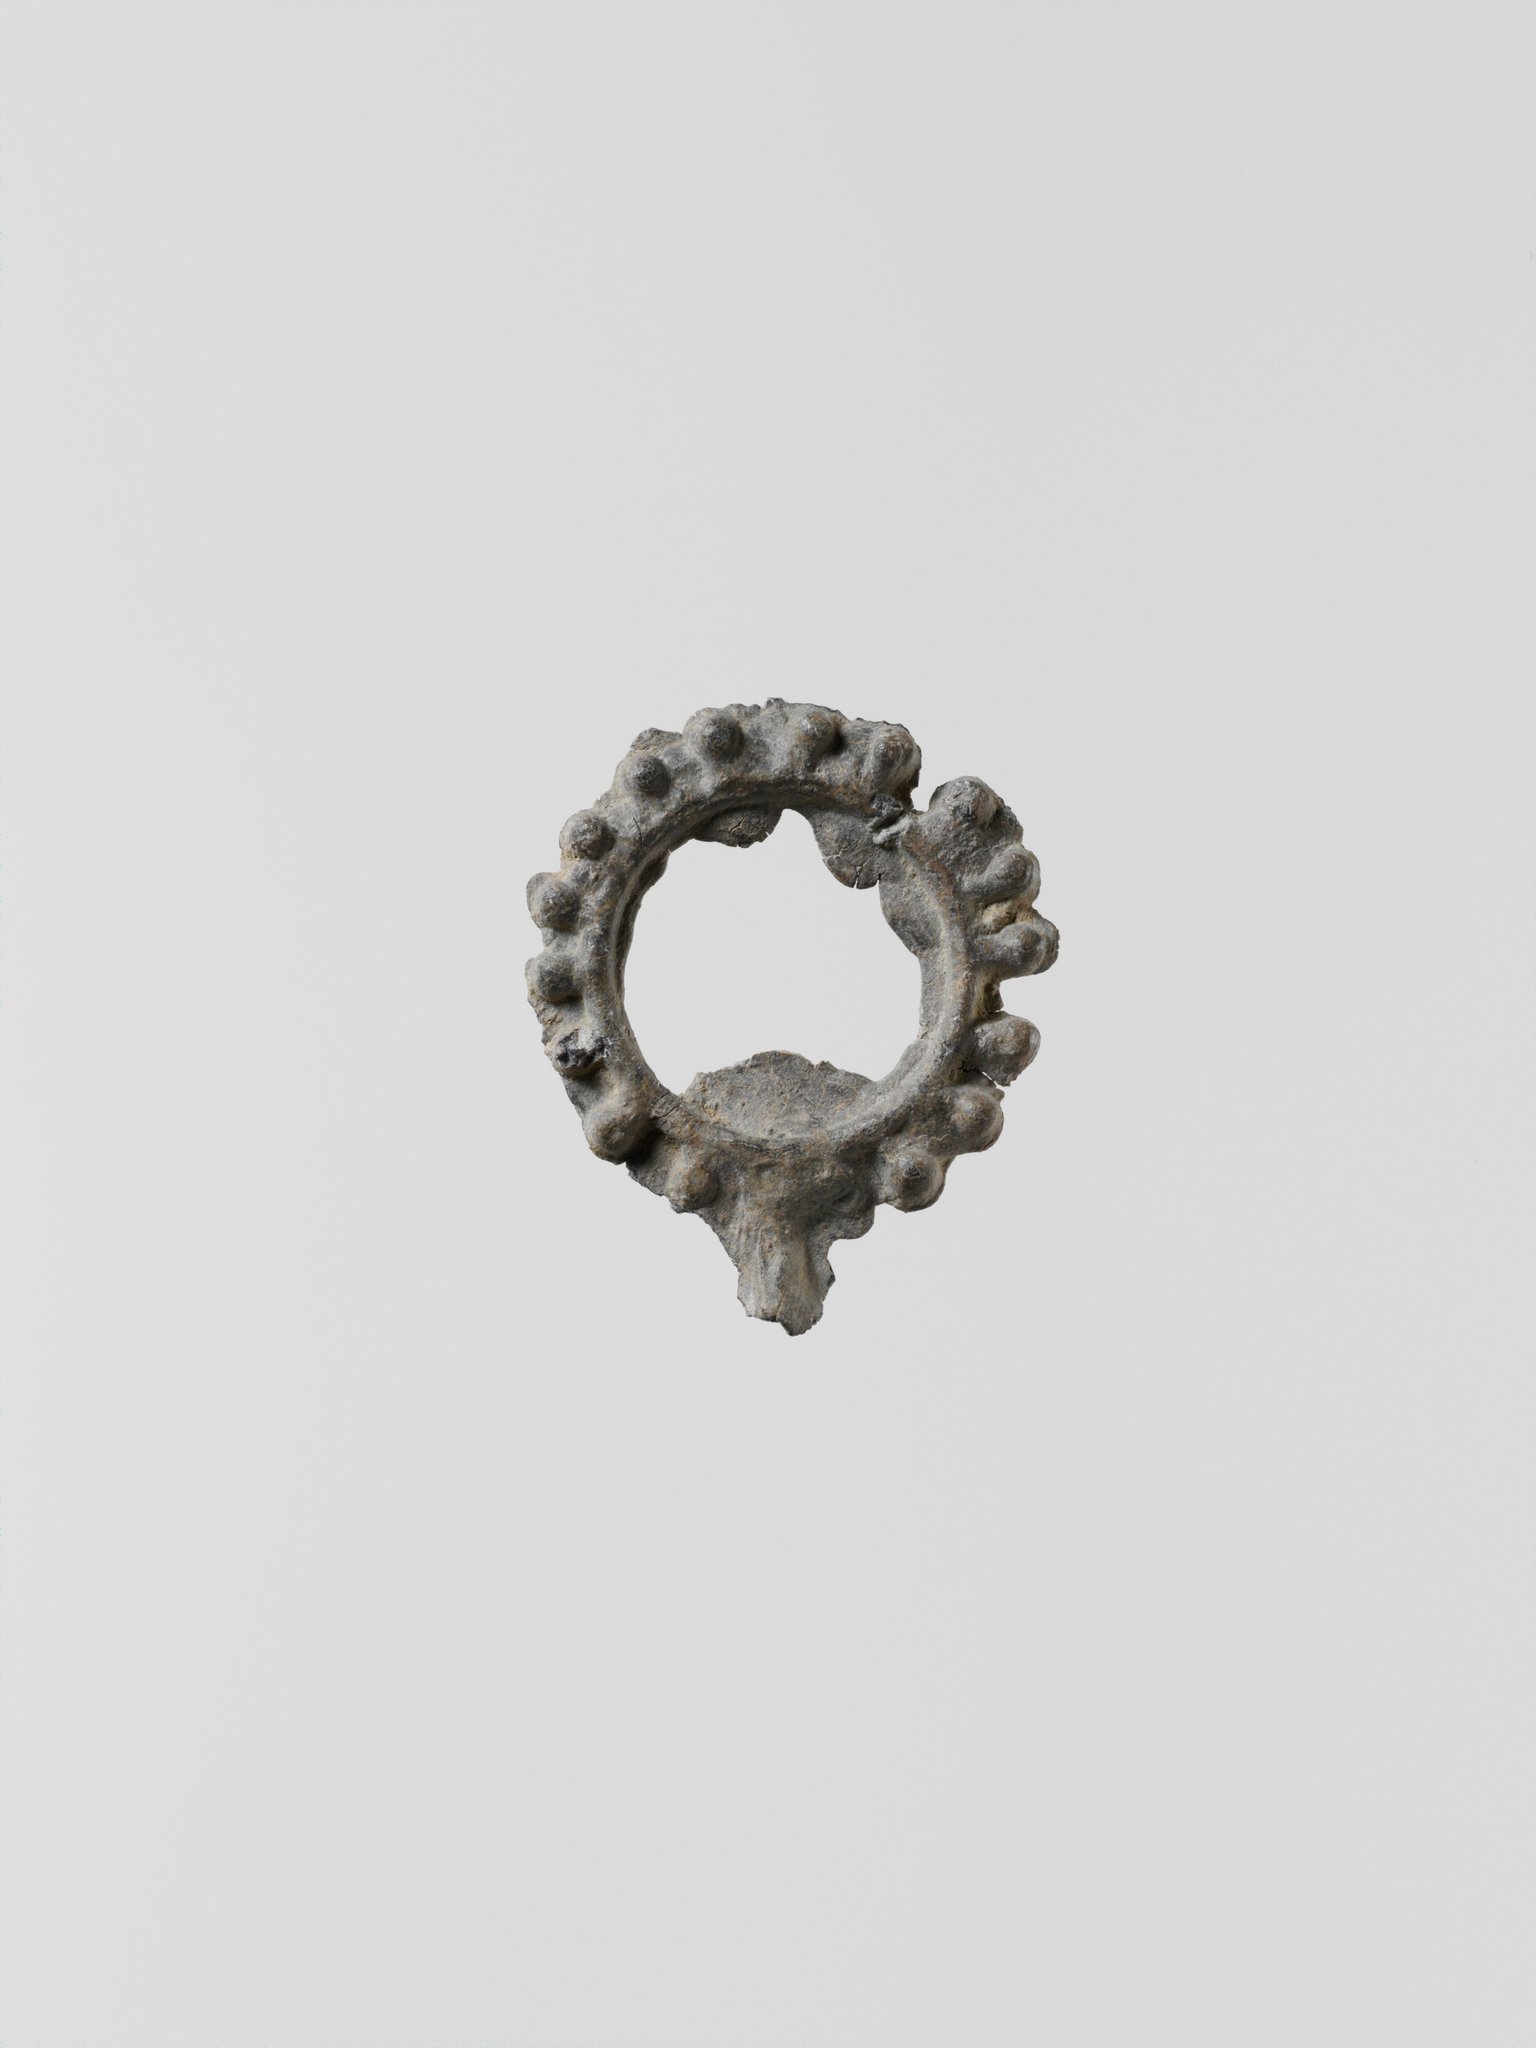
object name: wreath, 6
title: Wreaths, 6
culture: greek, laconian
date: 7000-30 BCE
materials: lead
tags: wreaths